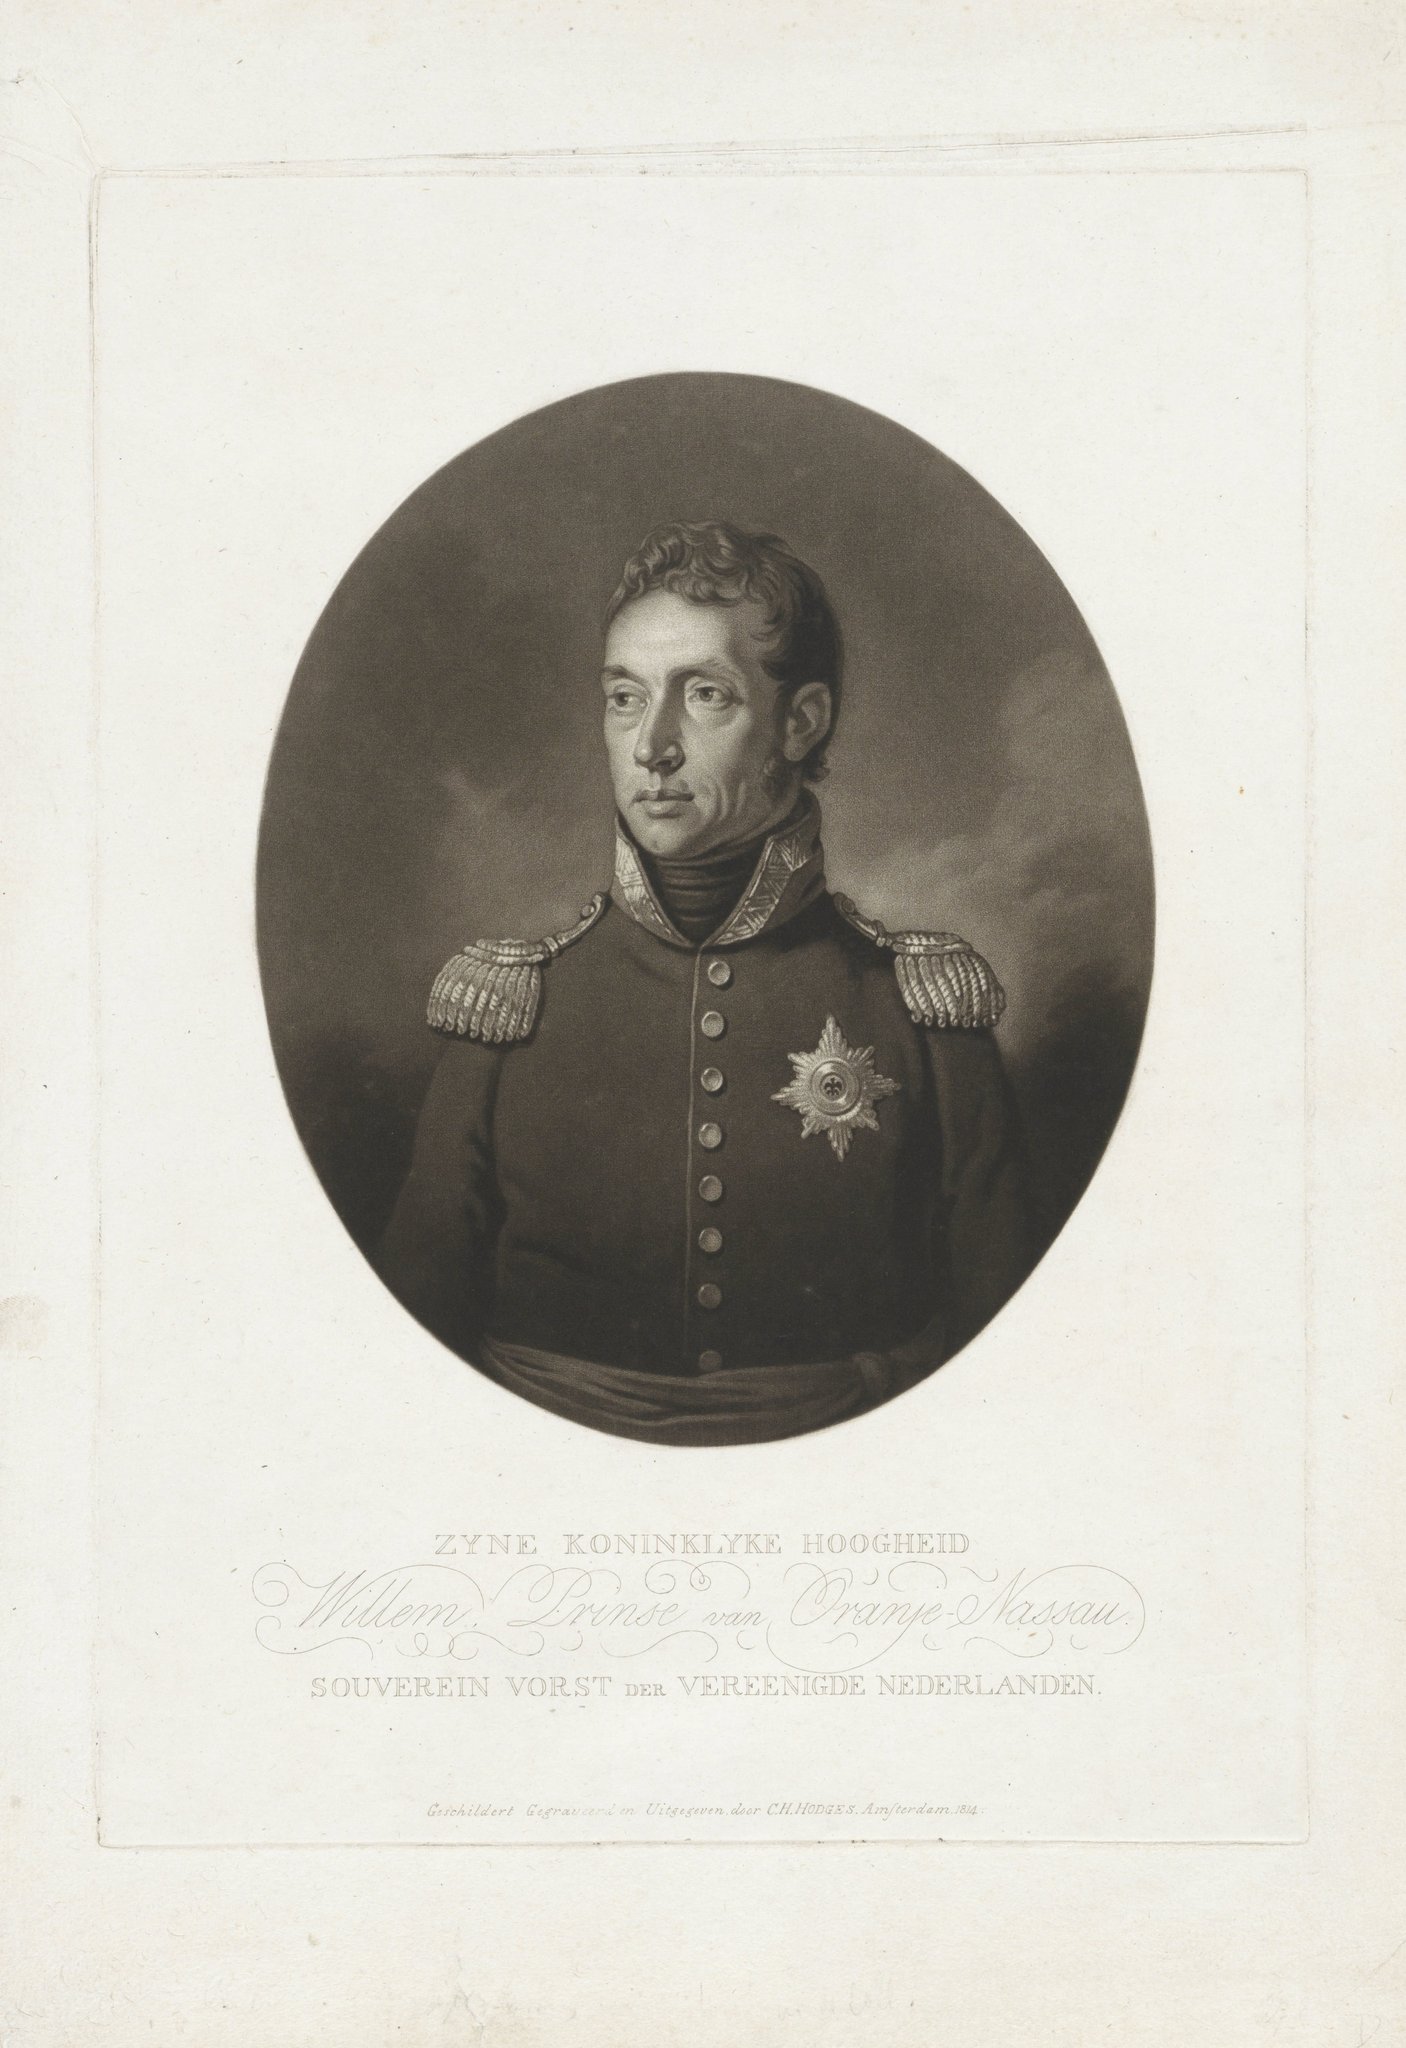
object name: print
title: Portret van Willem I Frederik, koning der Nederlanden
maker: charles howard hodges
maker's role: draughtsman, painter, print maker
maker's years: 1764-1837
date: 1814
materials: paper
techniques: engraving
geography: amsterdam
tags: william i of the netherlands, knighthood order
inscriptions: date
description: Portret van Willem I, souverein vorst der Verenigde Nederlanden, later koning der Nederlanden. Gedecoreerd met de ster van de Orde van de Kousenband.